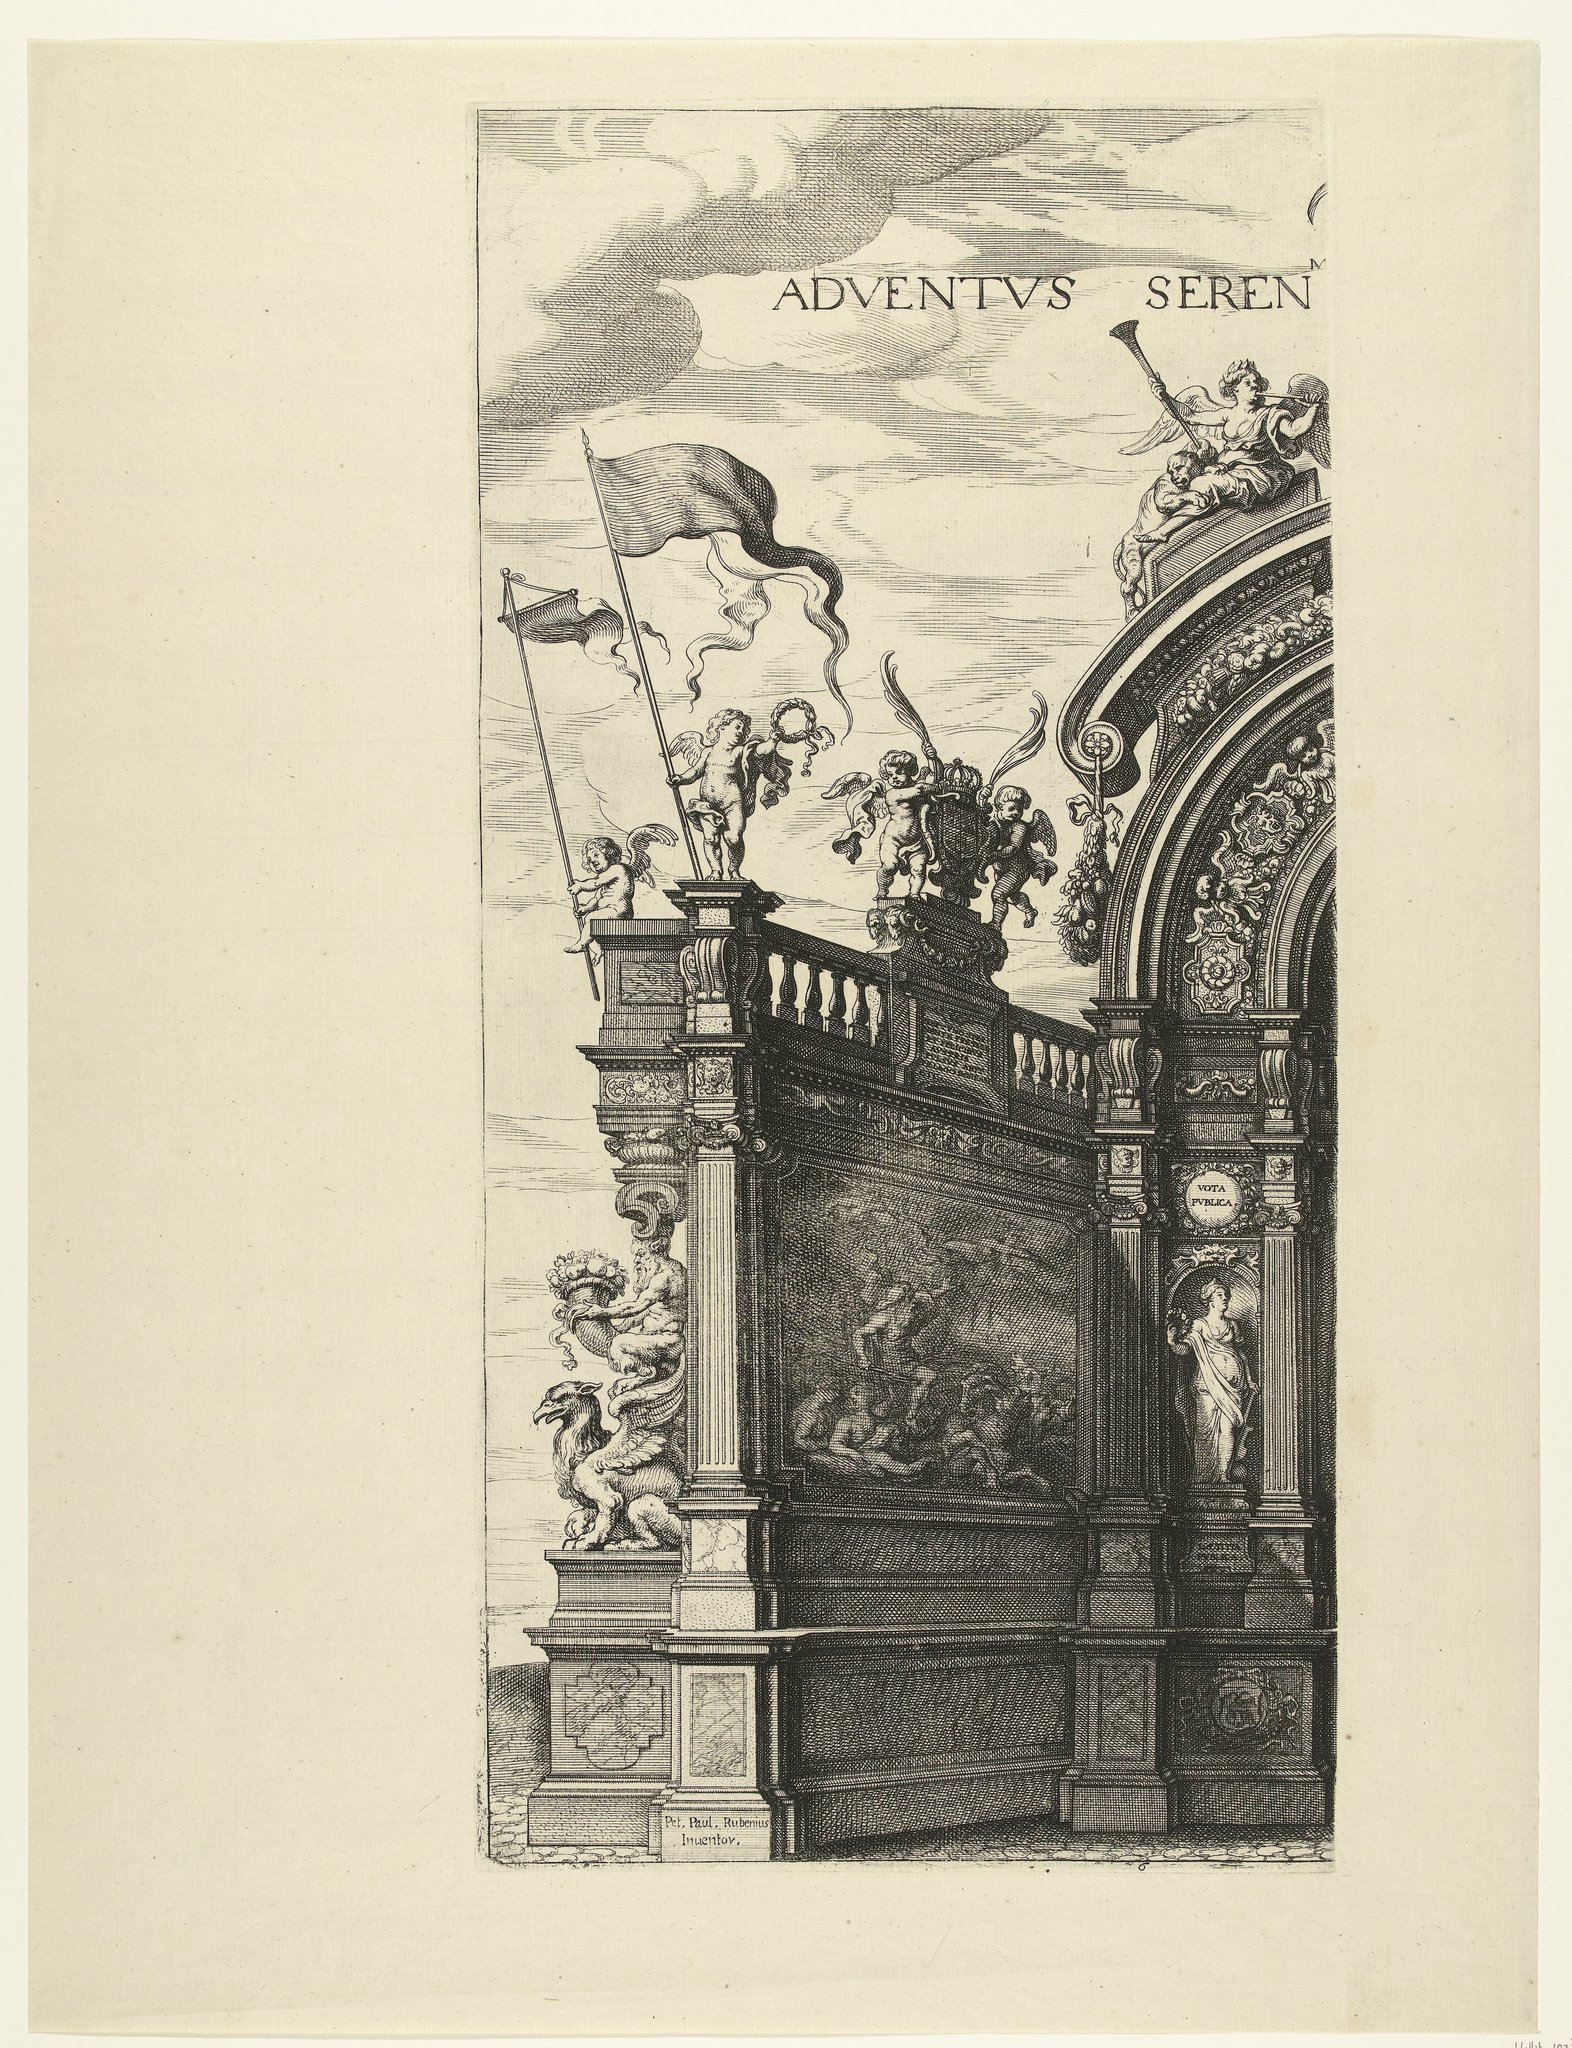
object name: print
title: Het welkomsttoneel; intocht van Ferdinand te Antwerpen in 1635 (nr. 6) (linkerhelft)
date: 1639-1641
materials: paper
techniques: engraving, etching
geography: southern netherlands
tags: brussels, landvoogd der zuidelijke nederlanden ferdinand van oostenrijk, triumphal entry and public reception, pageant, 'entrée solennelle', 'joyeuse entrée', antwerp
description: Oorspronkelijk gebruikt als illustratie in: C. Gevartius, Pompa introitus ... Ferdinandi Austriaci Hispaniarum Infantis ... a S.P.Q. Antverp, decreta et adornata, cum ... ad Norlingam parta victoria Antverpiam ... adventu suo bearet ... 1635 : arcus, pegmata iconesque a Pet. Paulo Rubenio ... inventas & delineatas inscriptionibus & elogiis ornabat, libroque commentario illustrabat, Theodoor van Thulden en Joannes Meursius, Antwerpen 1641, pl. 6.